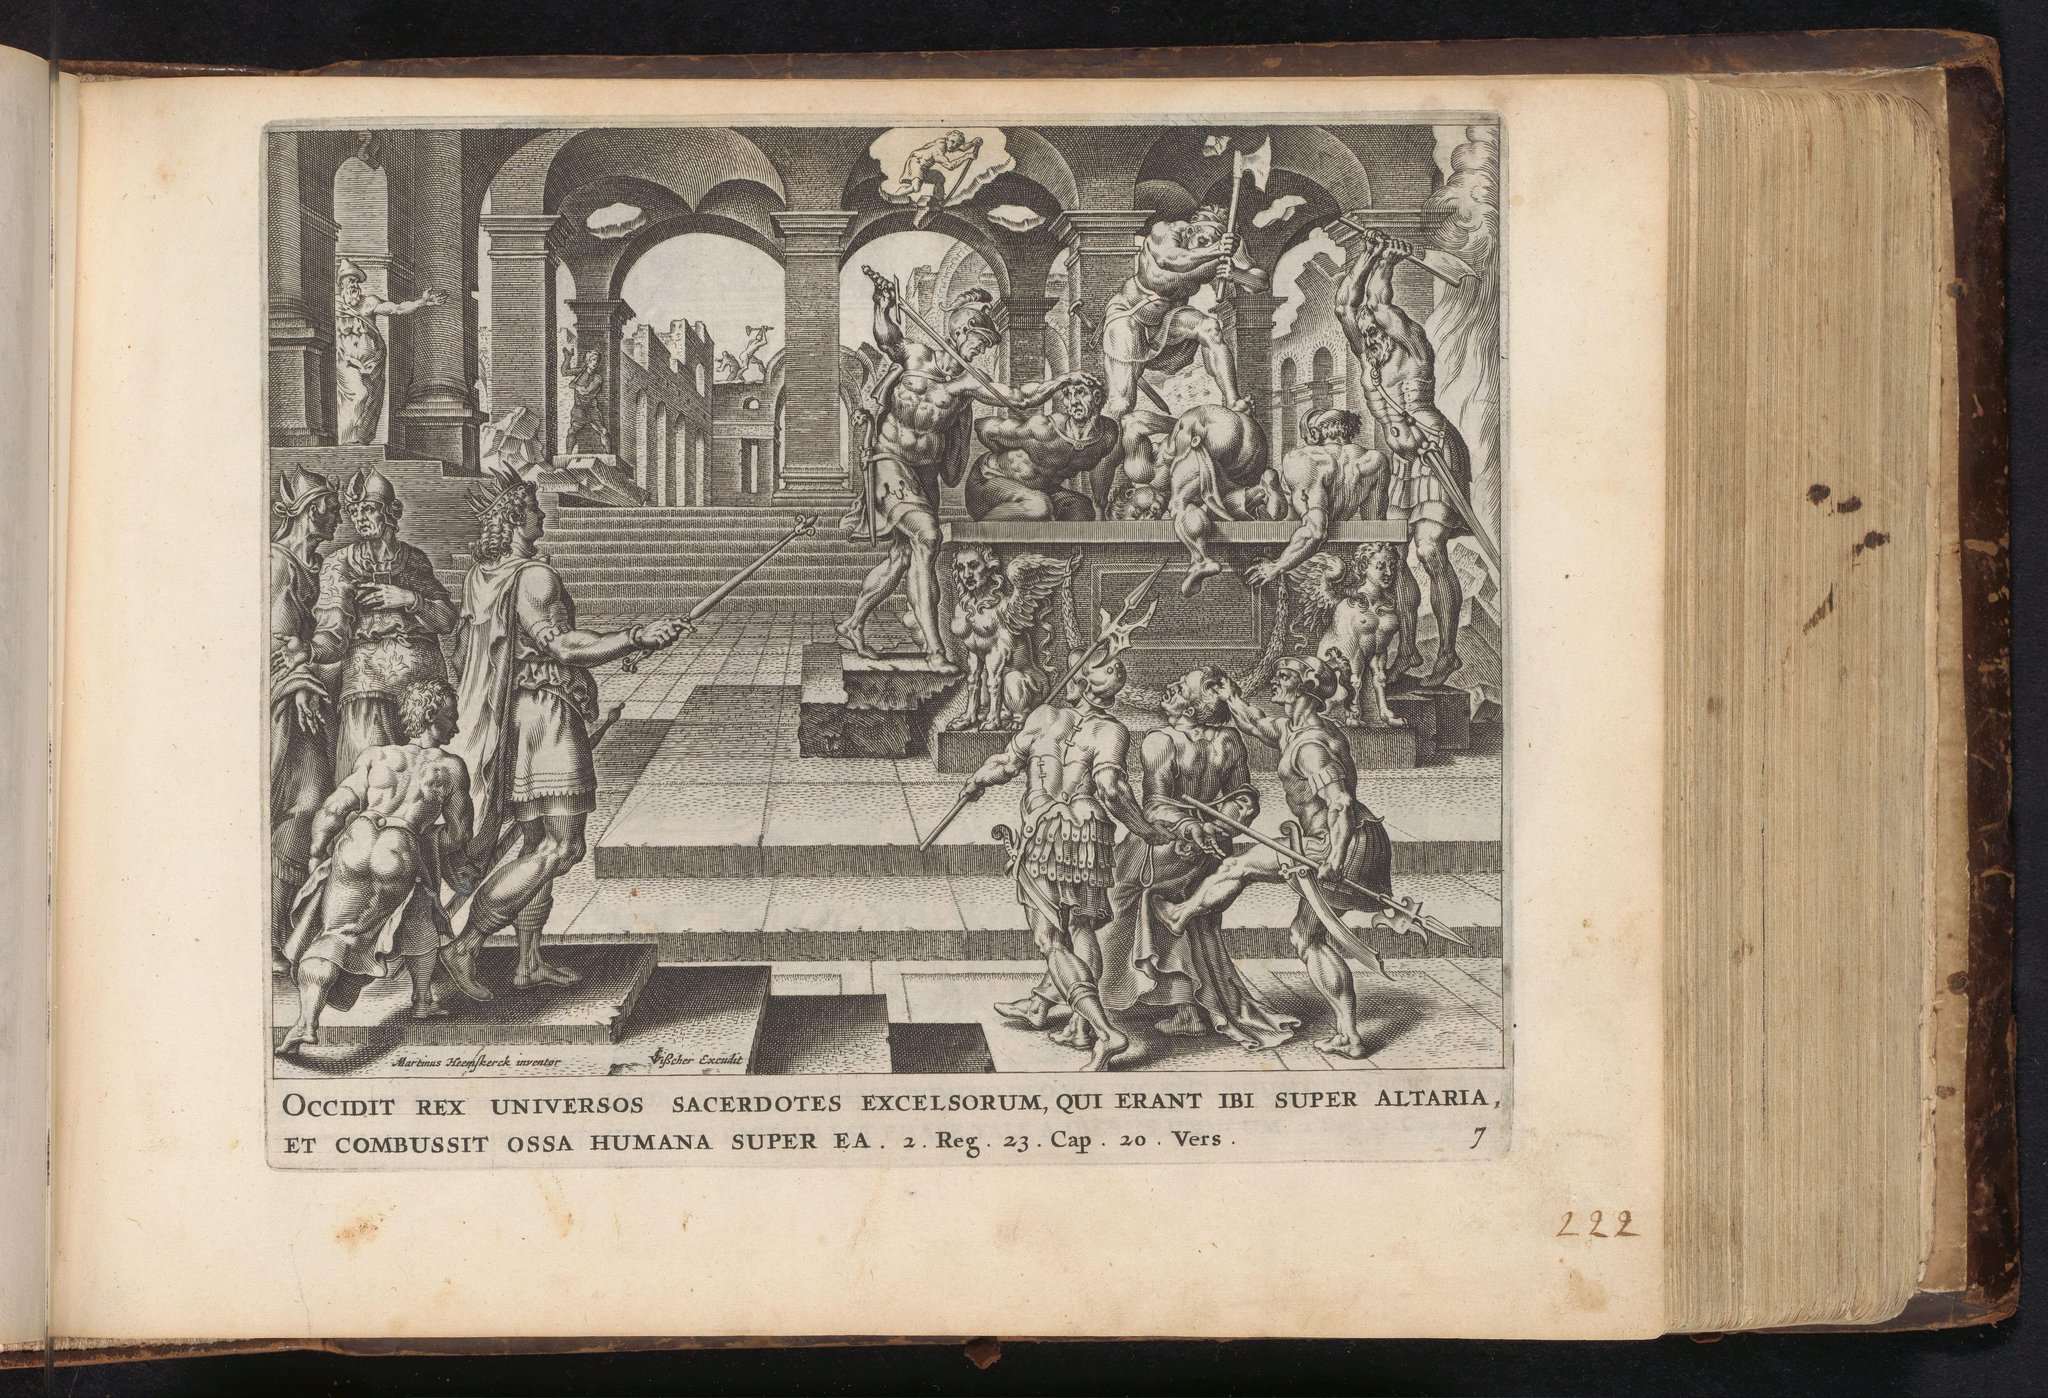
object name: album leaf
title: Van den Coninck Josias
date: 1643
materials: paper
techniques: engraving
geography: amsterdam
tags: the pagan priests are either killed or suppressed ~ story of josiah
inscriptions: number: ‘222’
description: Koning Josia staat in de tempel van Samaria en laat de priesters op de offeraltaren vermoorden. Soldaten van Josia slaan de priesters met bijlen en zwaarden. Onder de voorstelling een verwijzing in het Latijn naar de Bijbeltekst in 2 Kon. 23:20. Deze prent maakt deel uit van een album.